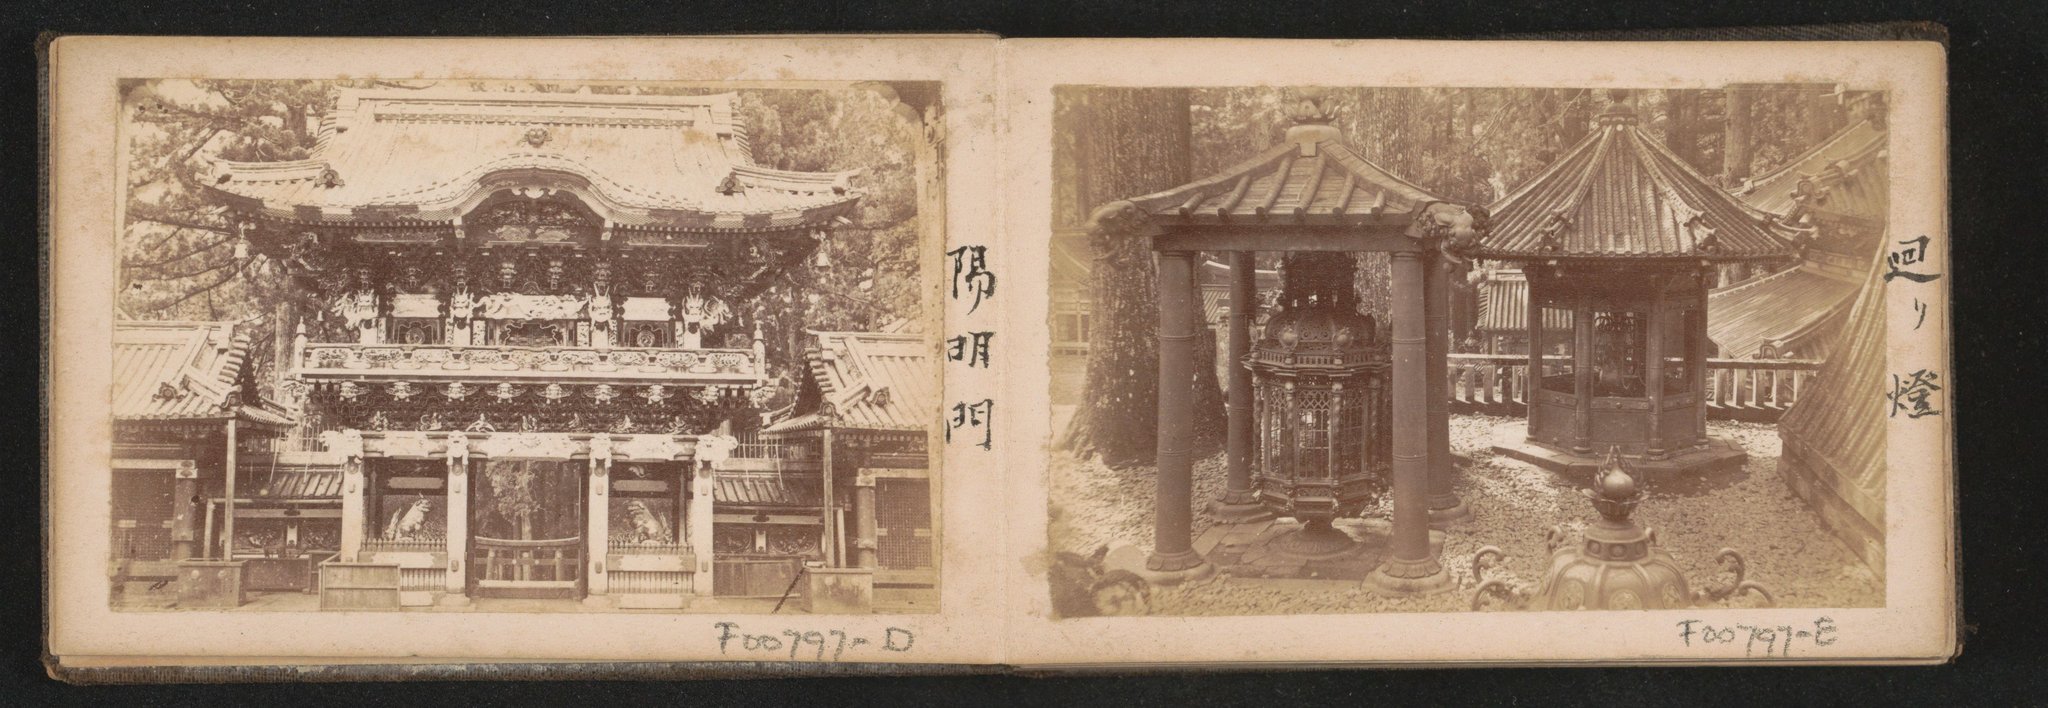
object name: album leaf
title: Toegangspoort van het Toshogu-heiligdom in Nikko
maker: Anonymous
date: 1870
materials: paper, photographic support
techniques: albumen print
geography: nikko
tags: temple, shrine ~ hinduism, buddhism, jainism, gate, entrance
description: Onderdeel van Leporelloalbum met 30 foto's van landschappen en gebouwen in Japan.